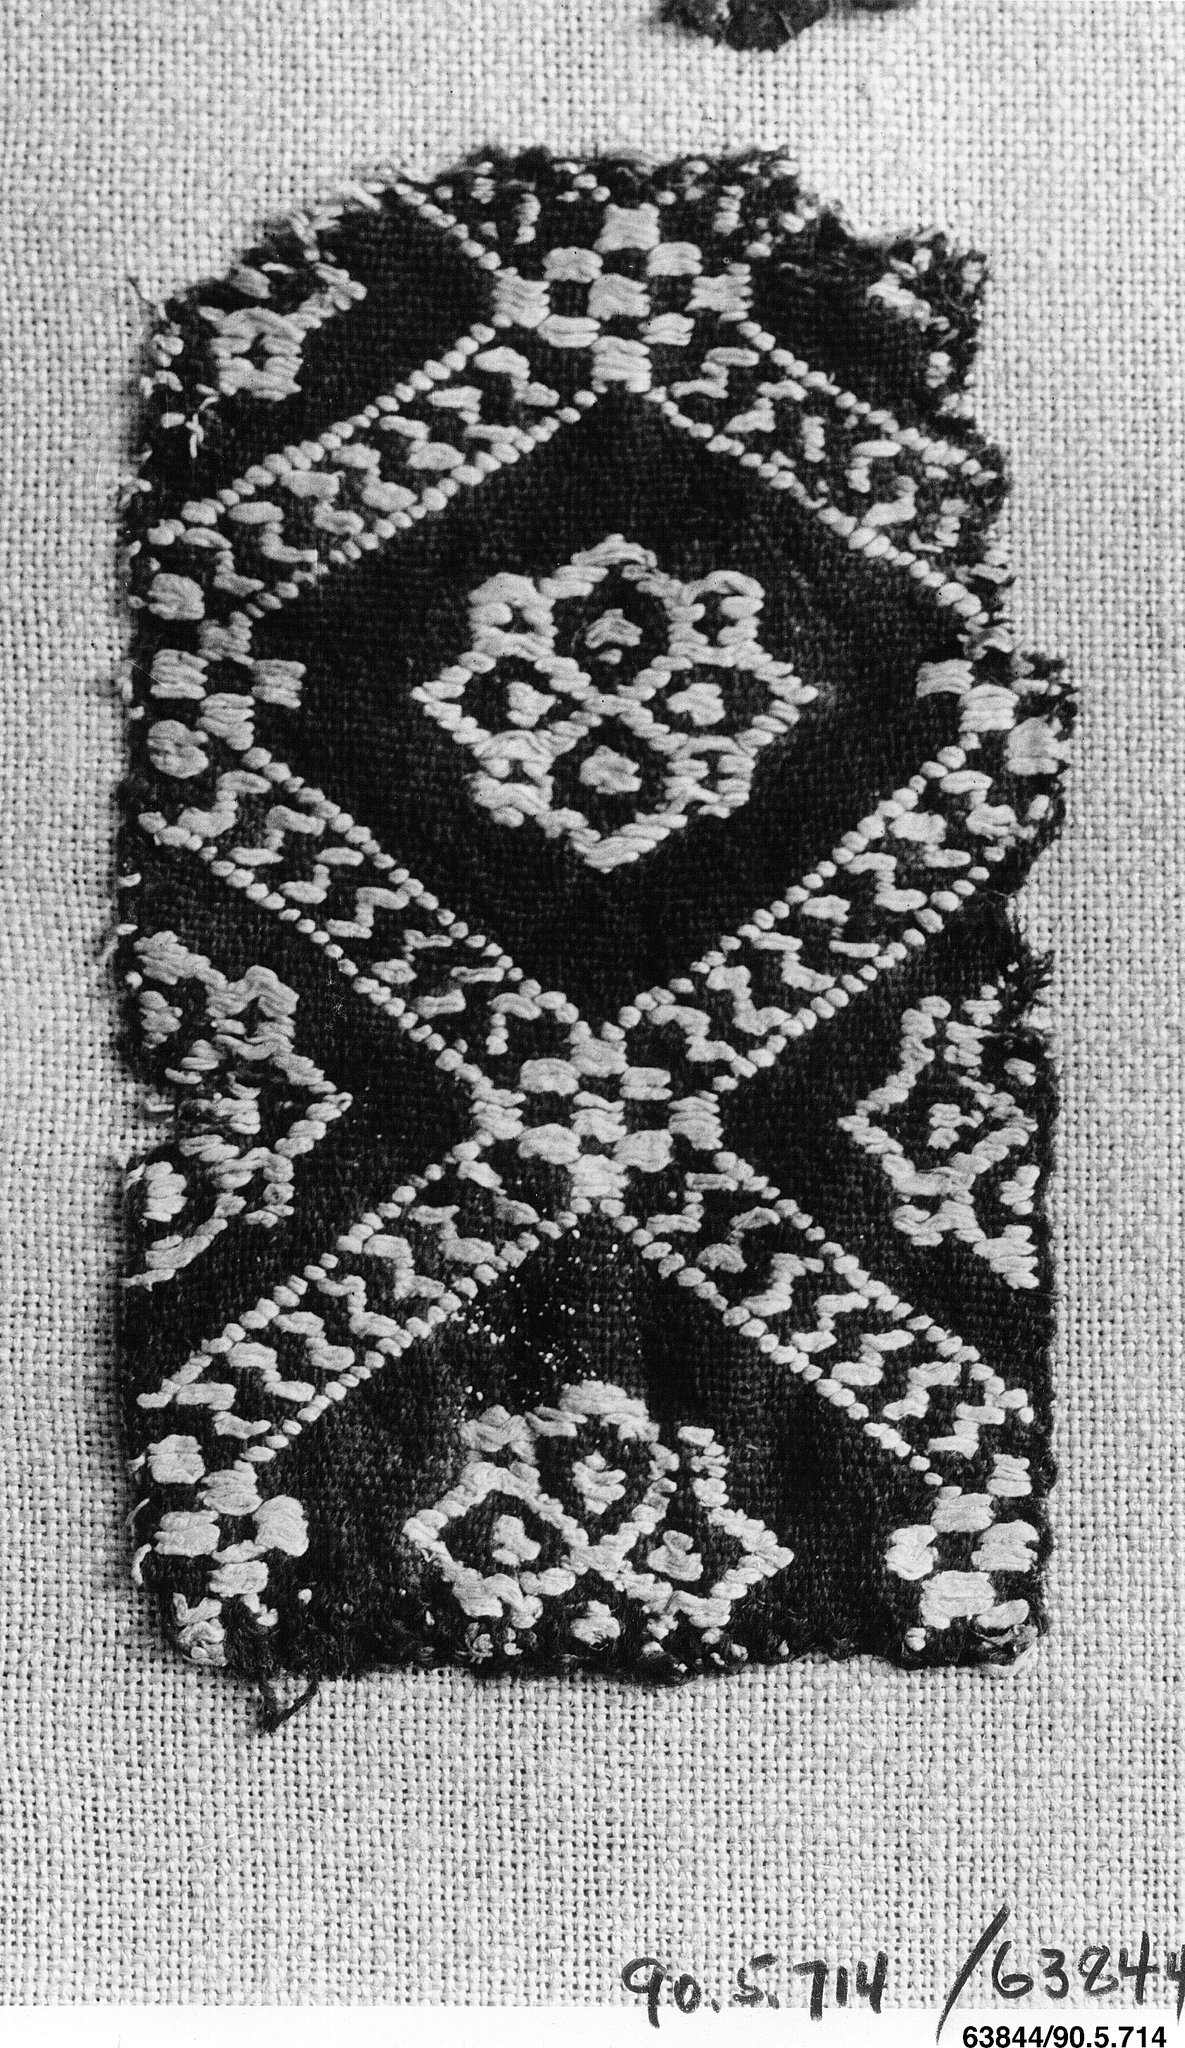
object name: textile fragment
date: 401-600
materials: linen, wool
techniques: brocade, weave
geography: egypt